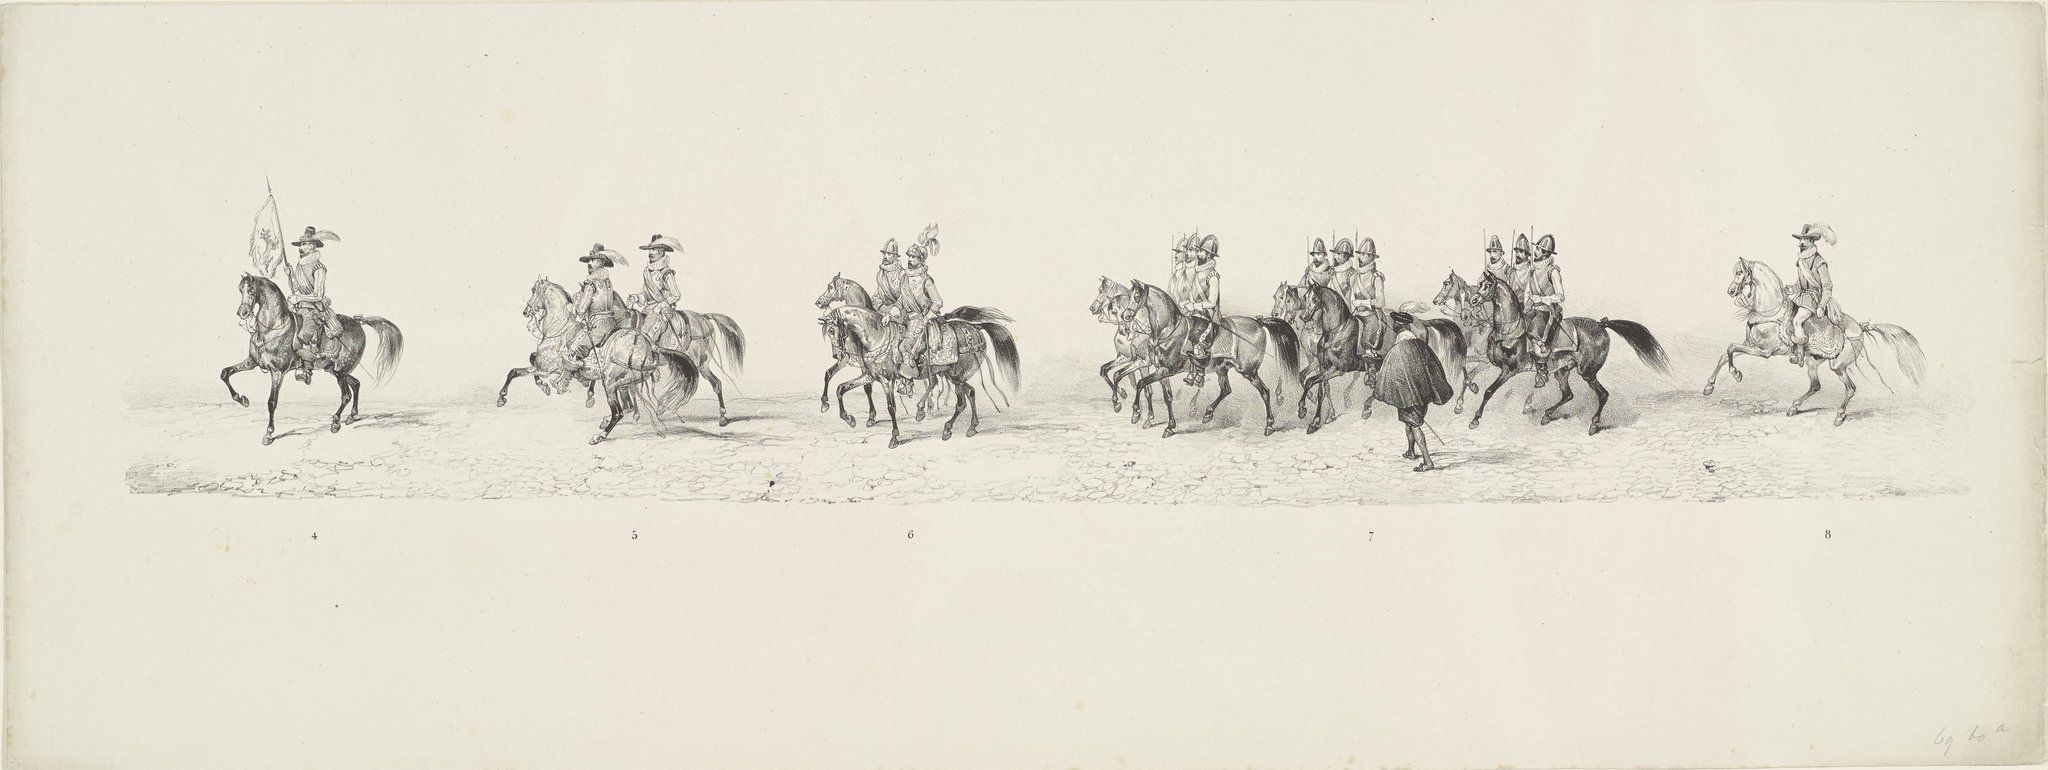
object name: print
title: Optogt des Nederlandschen Legers naar Ostende, den 3 July 1600, daags na de overwinning by Nieuwpoort; volgens de gecostumeerde voorstelling, gegeven door H H Studenten, by gelegenheid van het Tweede Eeuwfeest der Utrechtsche Hoogeschool. den 16 Juny 1836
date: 1837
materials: paper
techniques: lithograph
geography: france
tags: students' pageant, costumes used in pageants, battle of nieuwpoort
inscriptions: collector's mark: Lugt 2228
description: Historische gekostumeerde optocht van de studenten van de Hogeschool van Utrecht op 16 juni 1836, bij de viering van het tweede eeuwfeest van de Utrechtse Hogeschool. De optocht verbeeldt de intocht van het Staatse leger in Oostende op 3 juli 1600, daags na de overwinning in de Slag bij Nieuwpoort. Tweede plaat in een serie van tien ongenummerde platen, met de groepen genummerd 4-8.